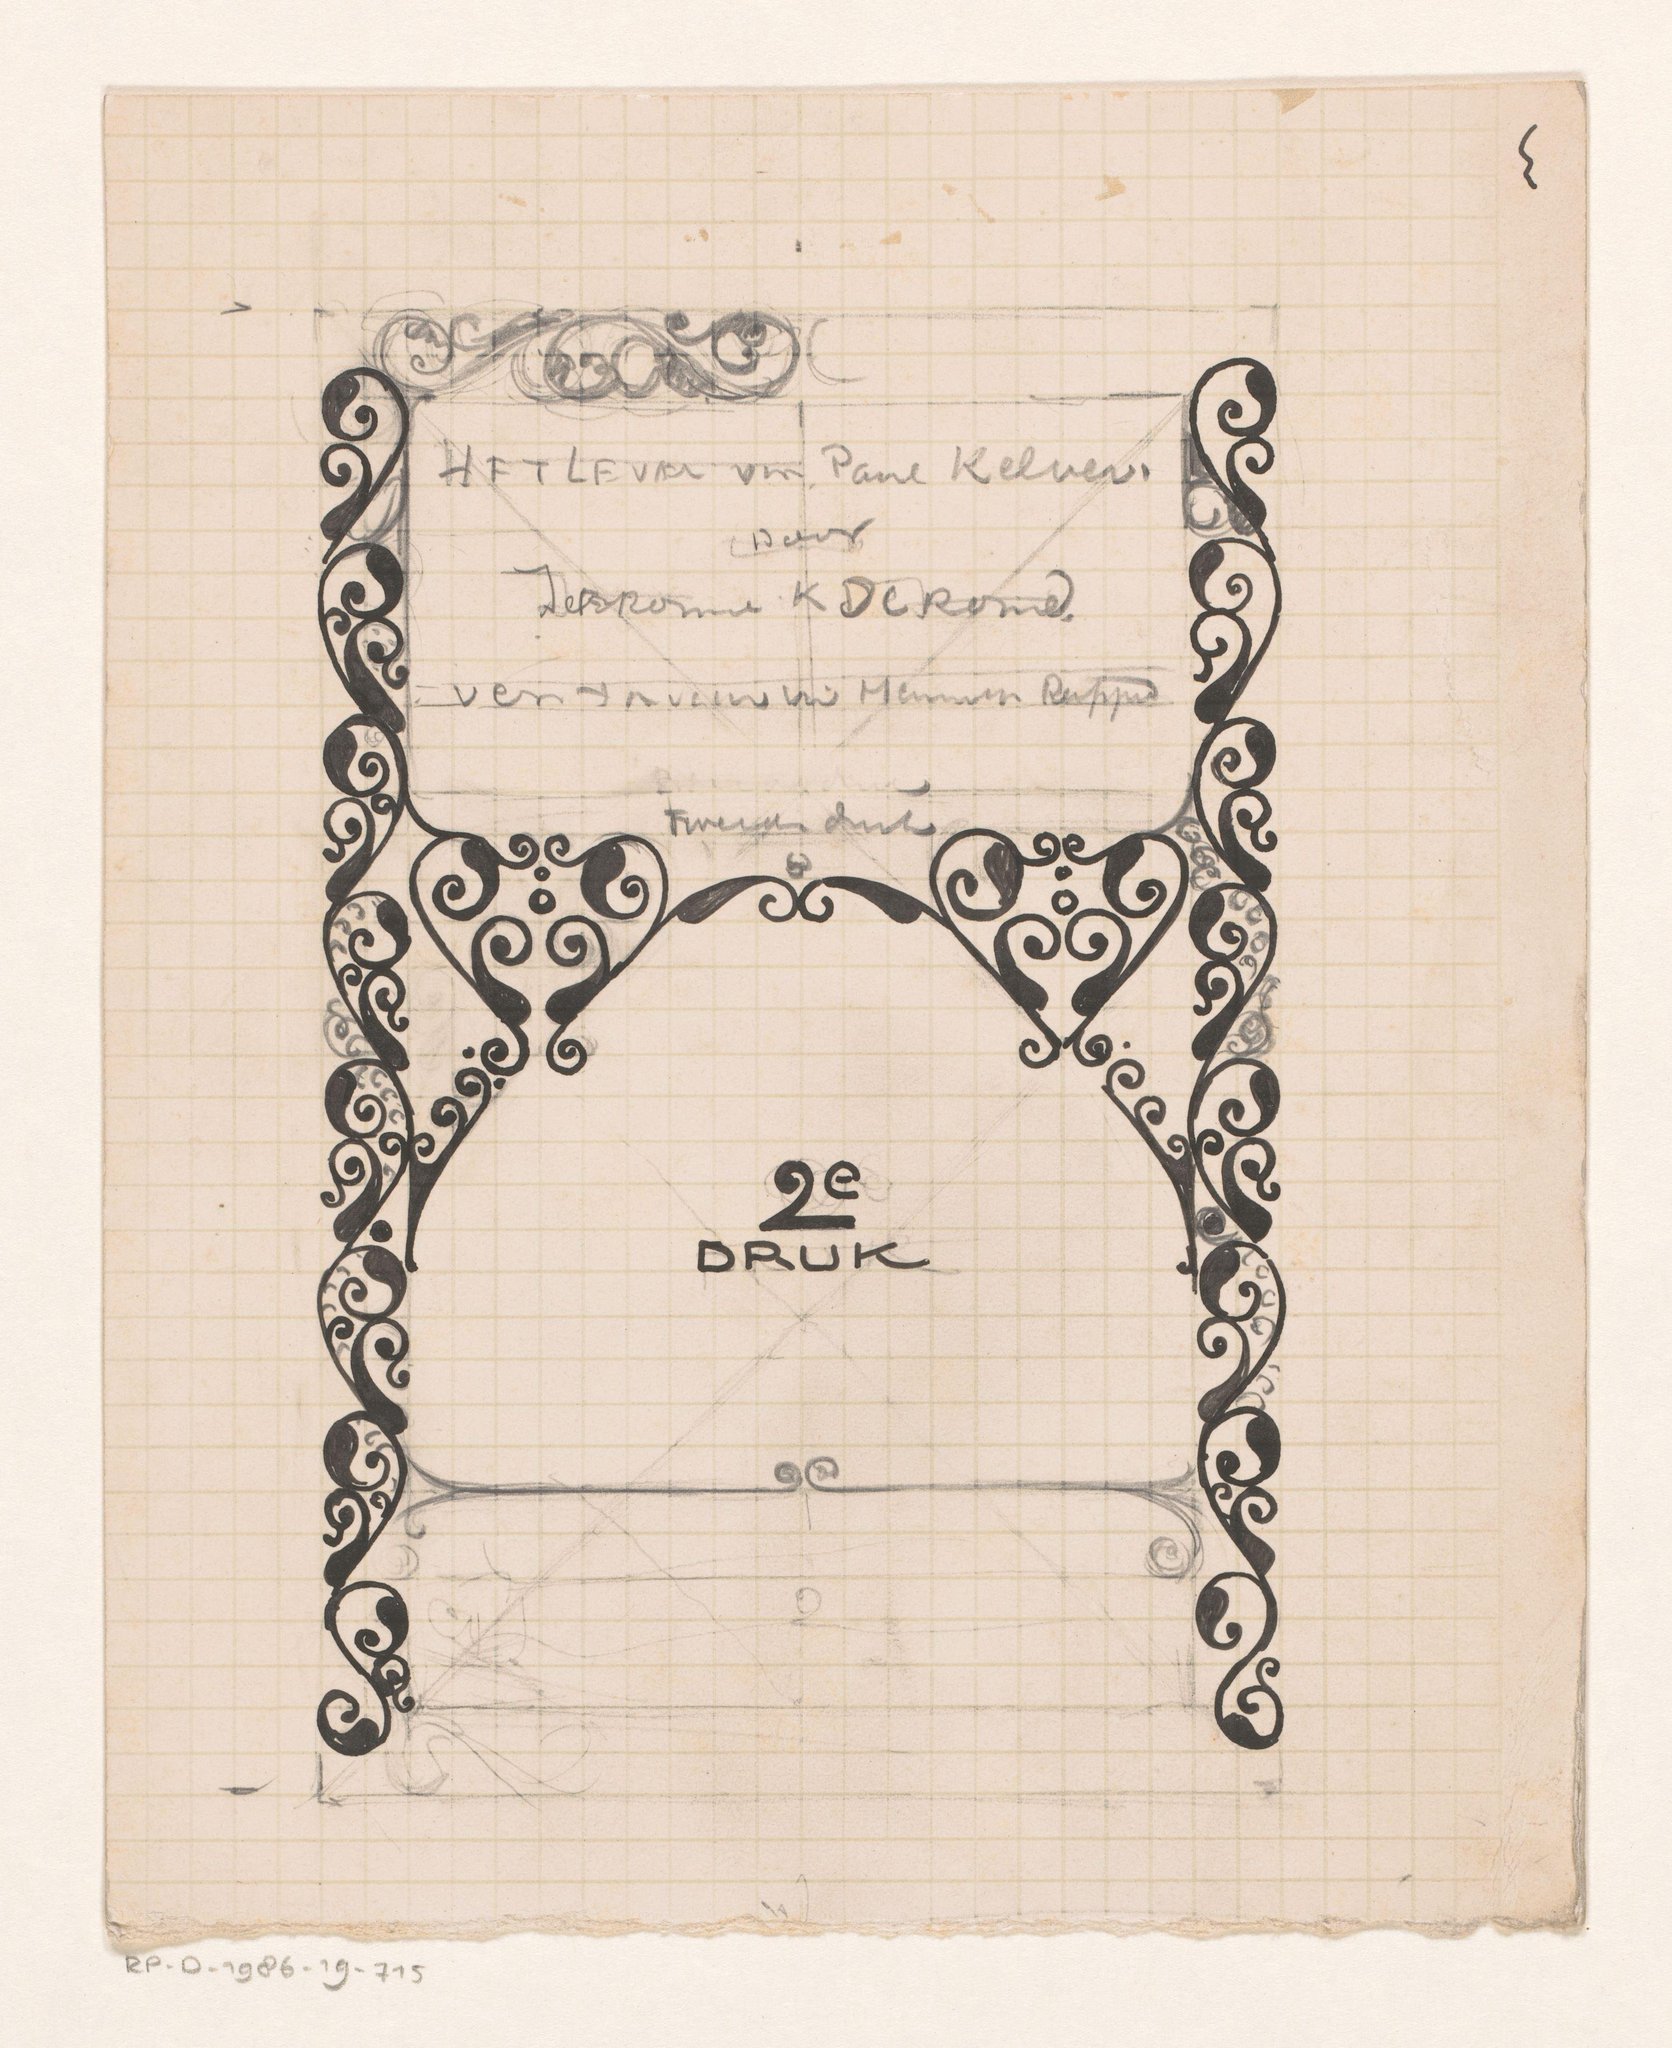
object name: drawing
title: Bandontwerp voor: Jerome K. Jerome, Het leven van Paul Kelver, c. 1923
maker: reinier willem petrus de vries (1874-1953)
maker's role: draughtsman, print maker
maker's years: 1874-1953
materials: ink, pencil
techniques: brush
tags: ornament ~ round and curved forms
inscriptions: collector's mark: ‘R:MVS.’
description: Bandontwerp voor: Jerome, Jerome K. Het leven van Paul Kelver. Baarn: Hollandia-Drukkerij, 1923.